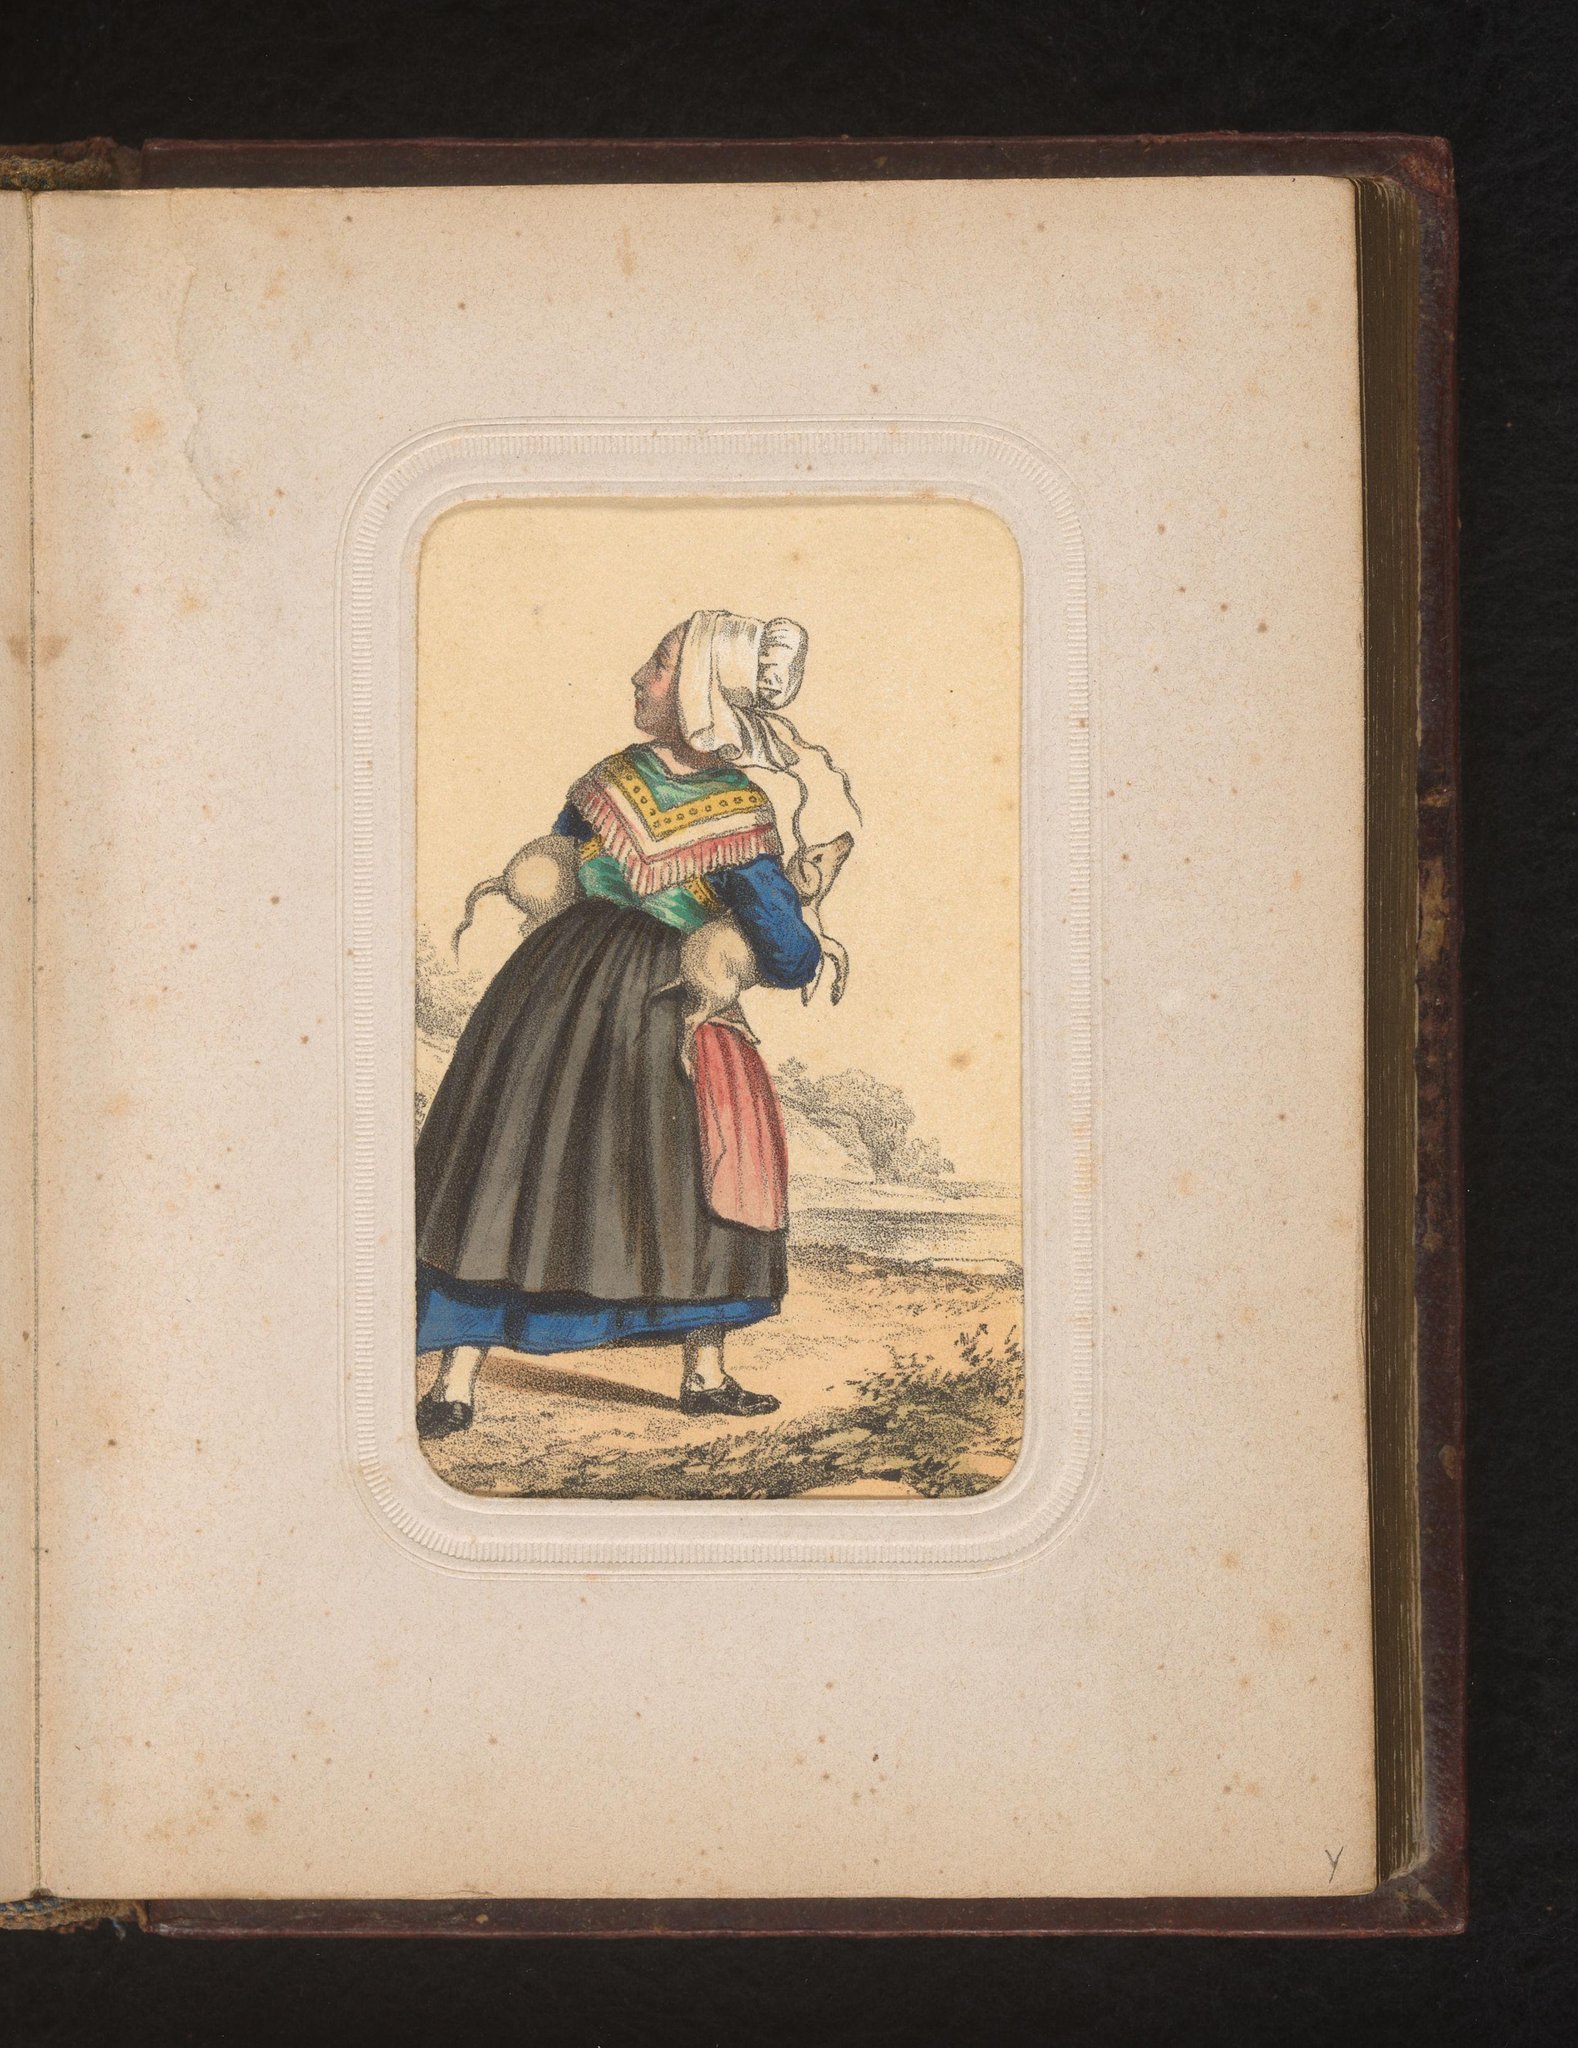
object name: album leaf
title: Meisje in klederdracht met biggen onder haar armen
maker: Anonymous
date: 1860-1900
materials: cardboard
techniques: lithograph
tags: girl (child between toddler and youth), piglet, suckling pig, folk costume, regional costume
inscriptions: inscription: ‘ROSPORDEN, Arrondt. de Quimper.’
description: Deze prent maakt deel uit van een album.